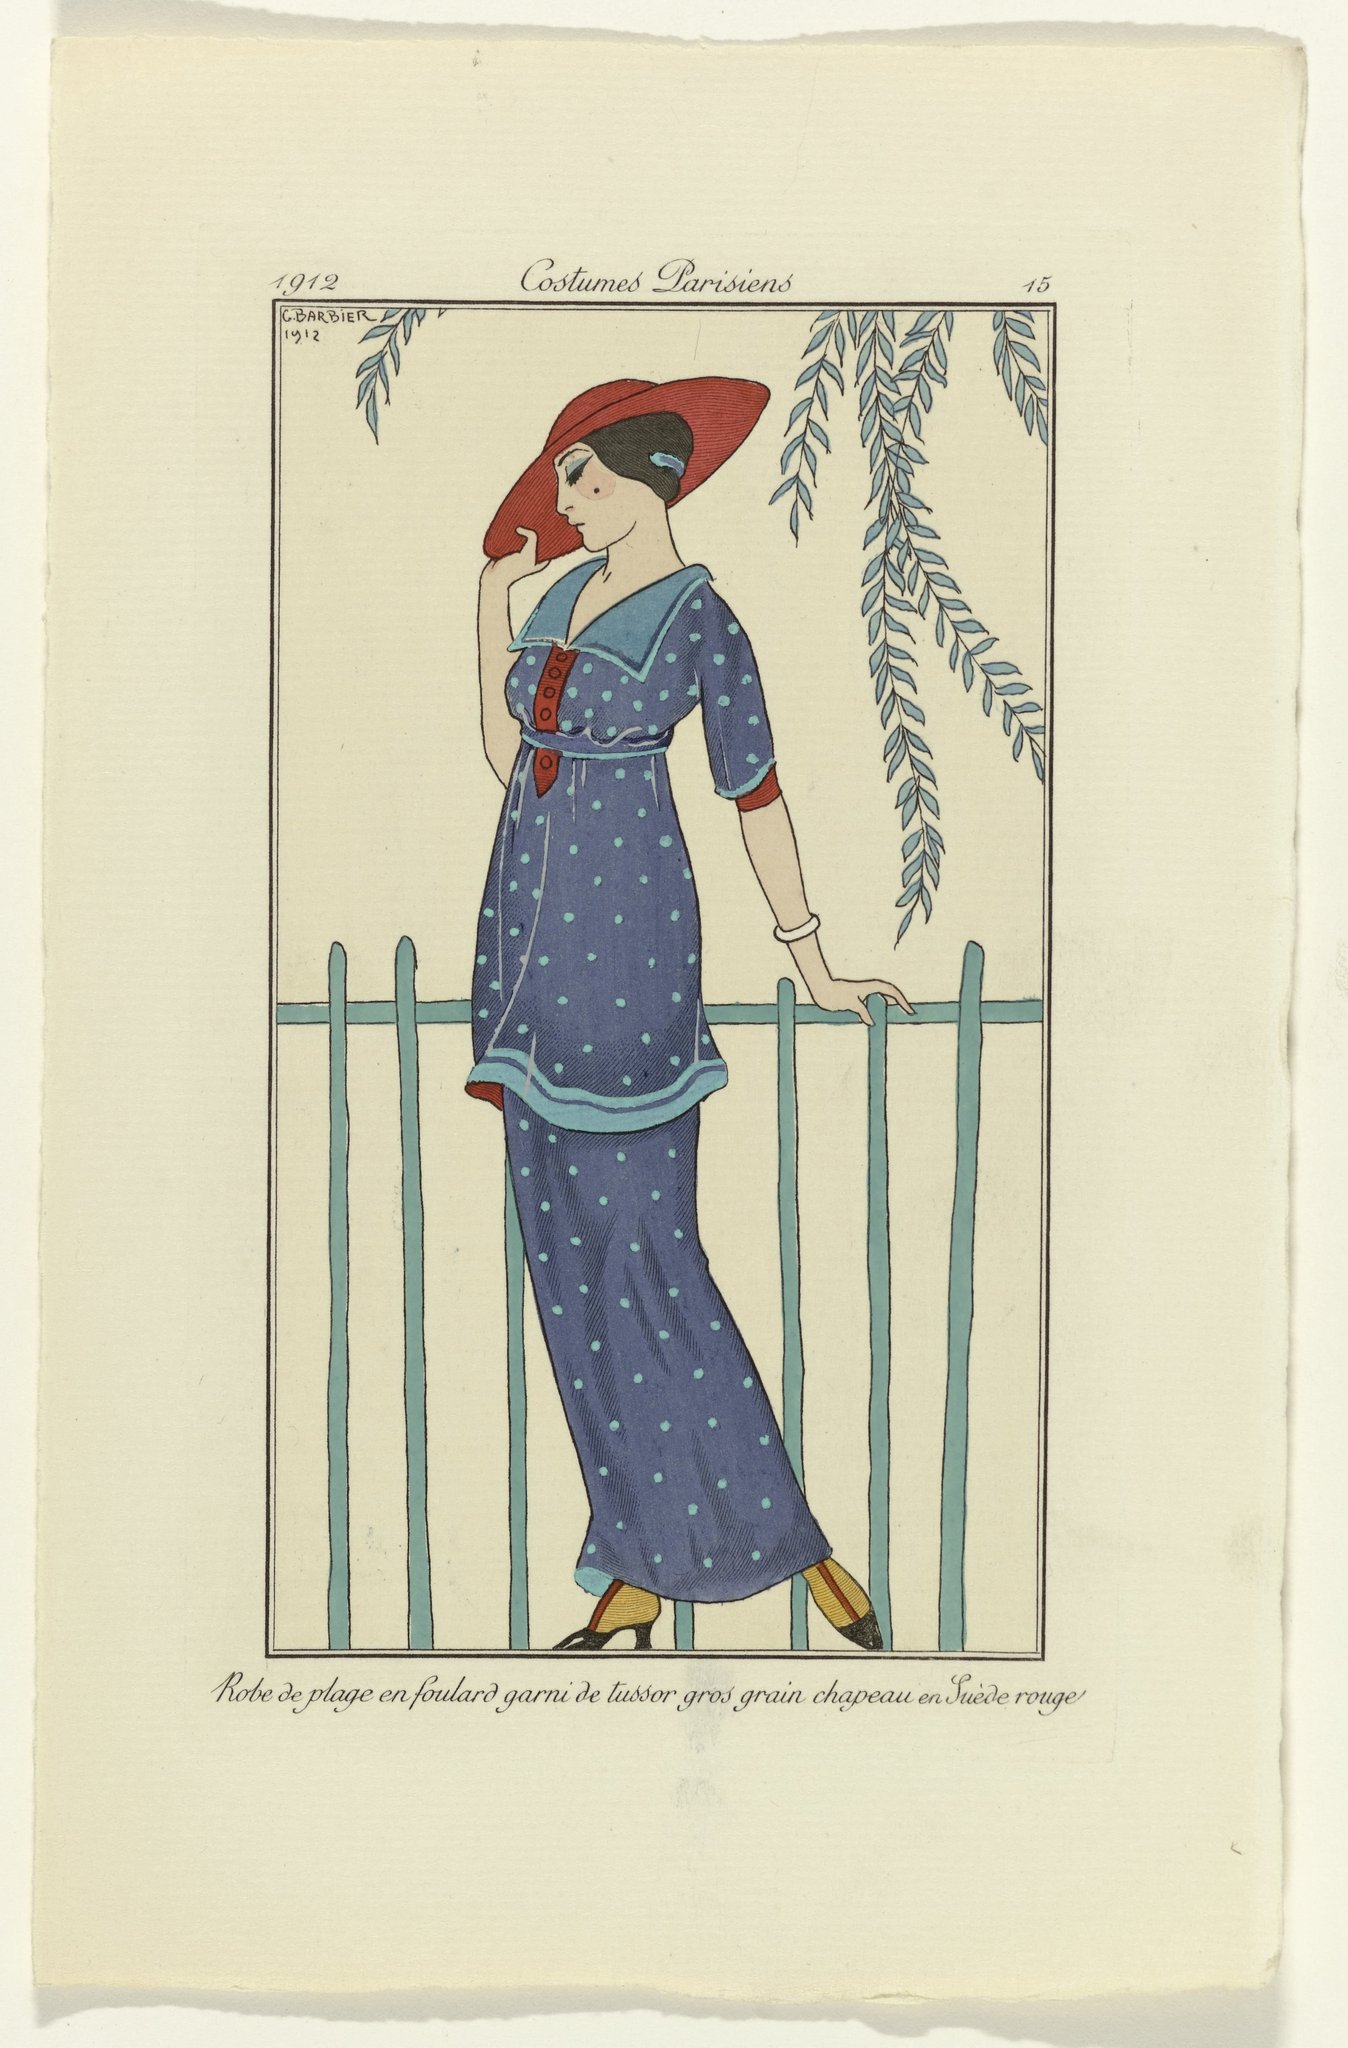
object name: fashion print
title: Journal des Dames et des Modes, 1912, Costumes Parisiens, no. 15: Tobe de plag (...)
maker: Anonymous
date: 1912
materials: paper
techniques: engraving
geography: paris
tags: fashion plates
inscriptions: caption